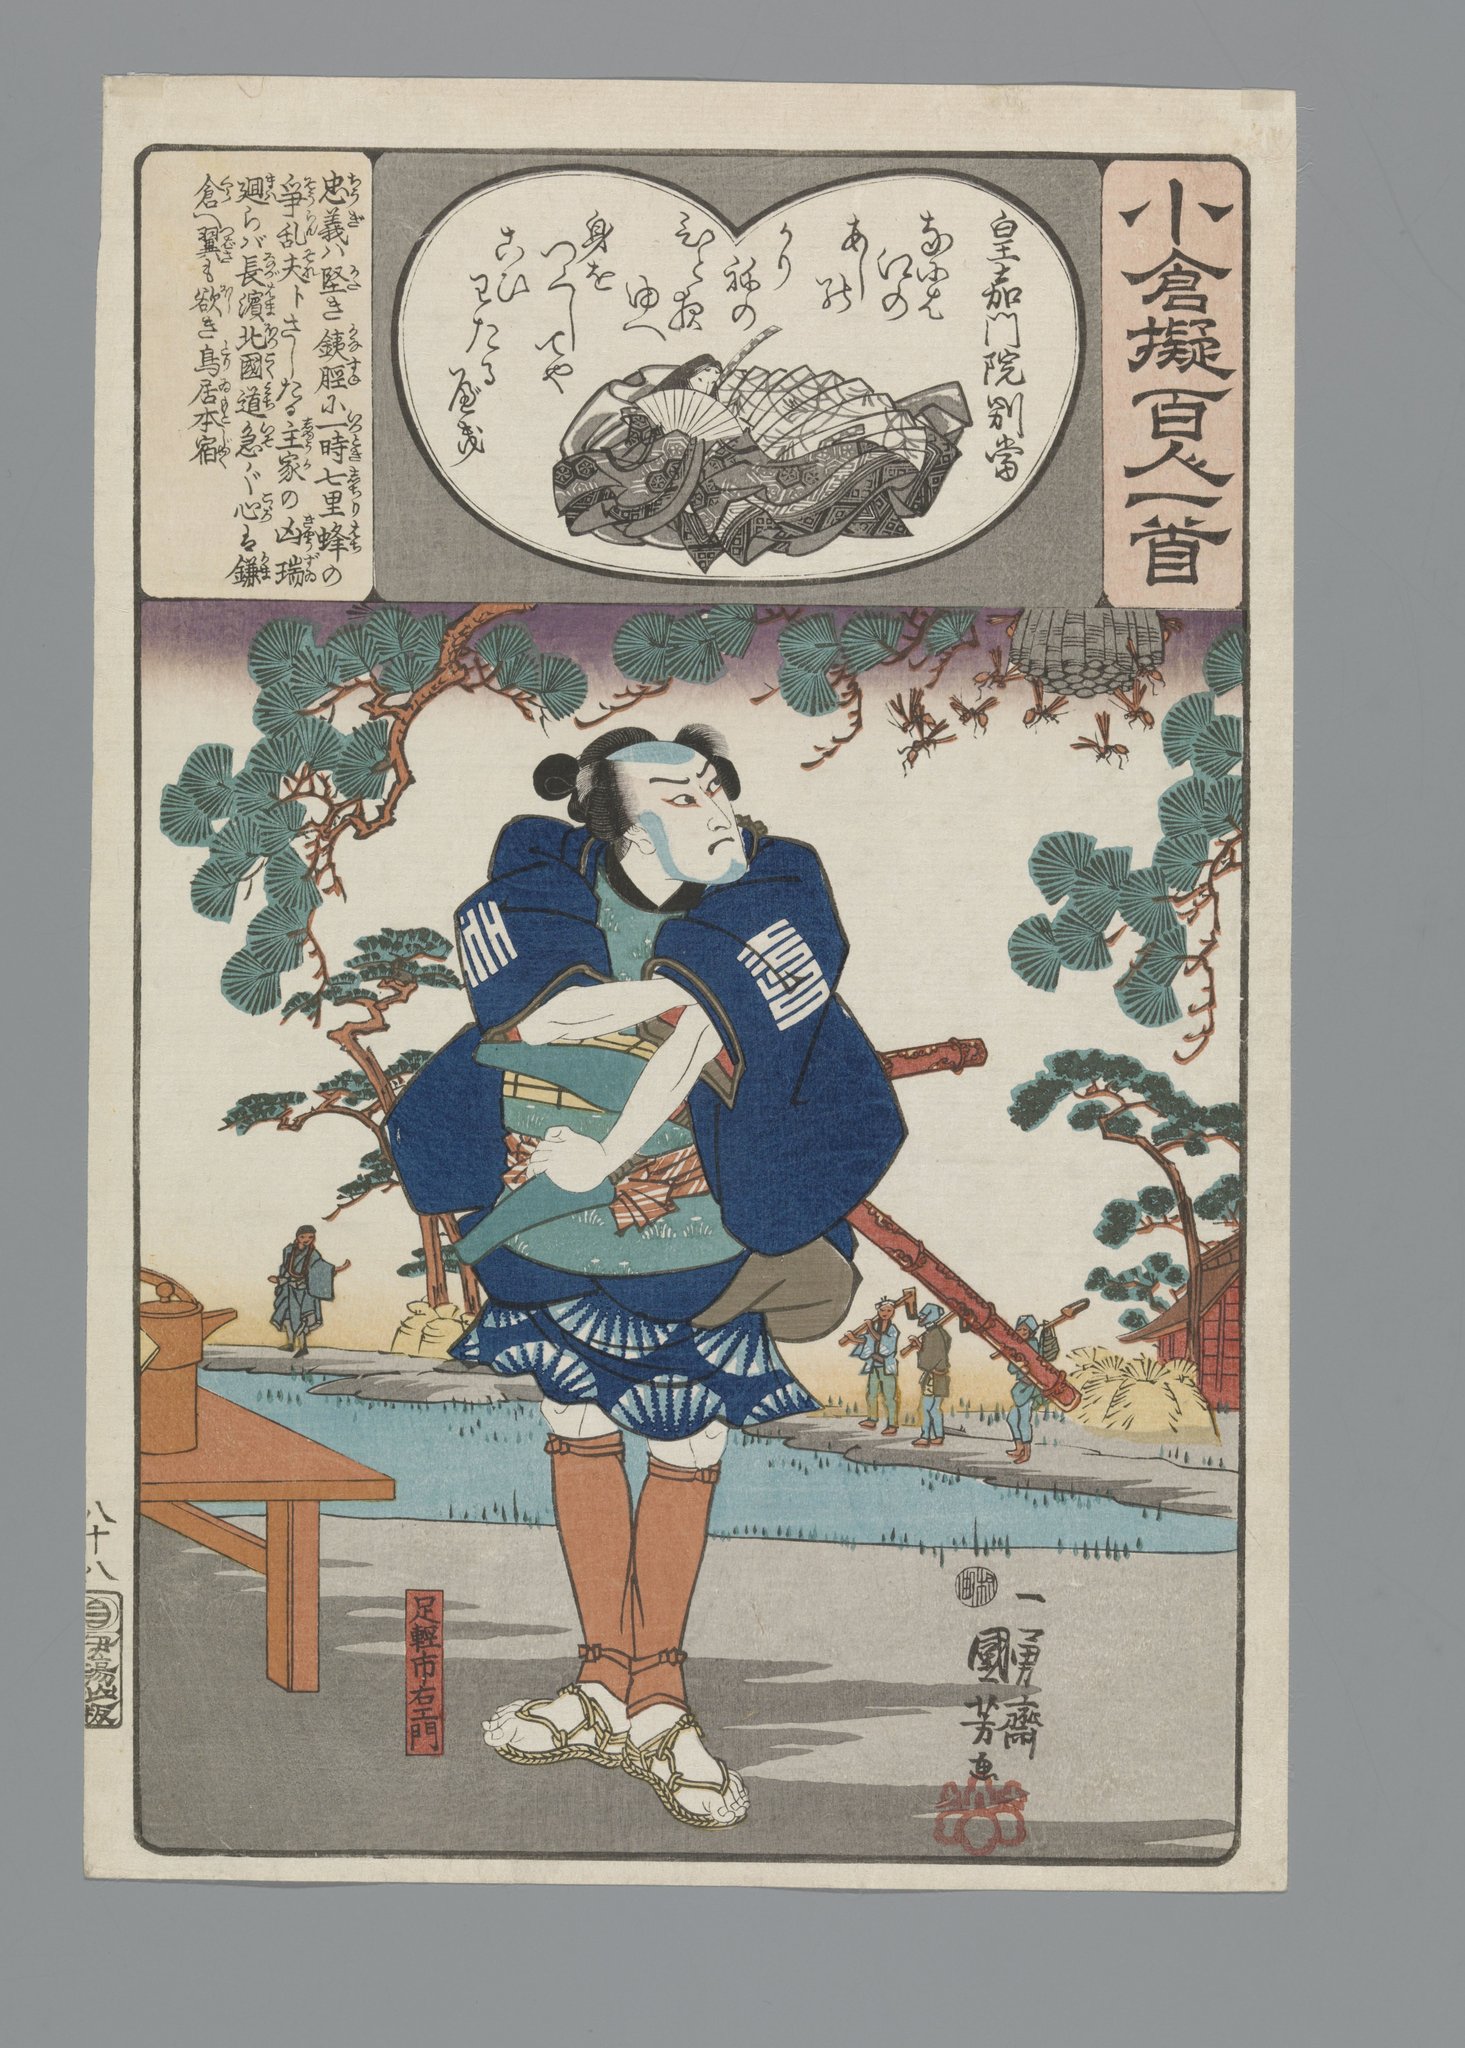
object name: print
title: Ogura Imitation of the One Hundred Poems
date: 1846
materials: paper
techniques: woodcut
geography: japan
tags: adult man, water course, bee-hive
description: Ichiemon kijkt naar een bijenkorf in een pijnboom. Scene uit een kabukitoneelstuk. Gedicht door Kôka Monin no Bettô.